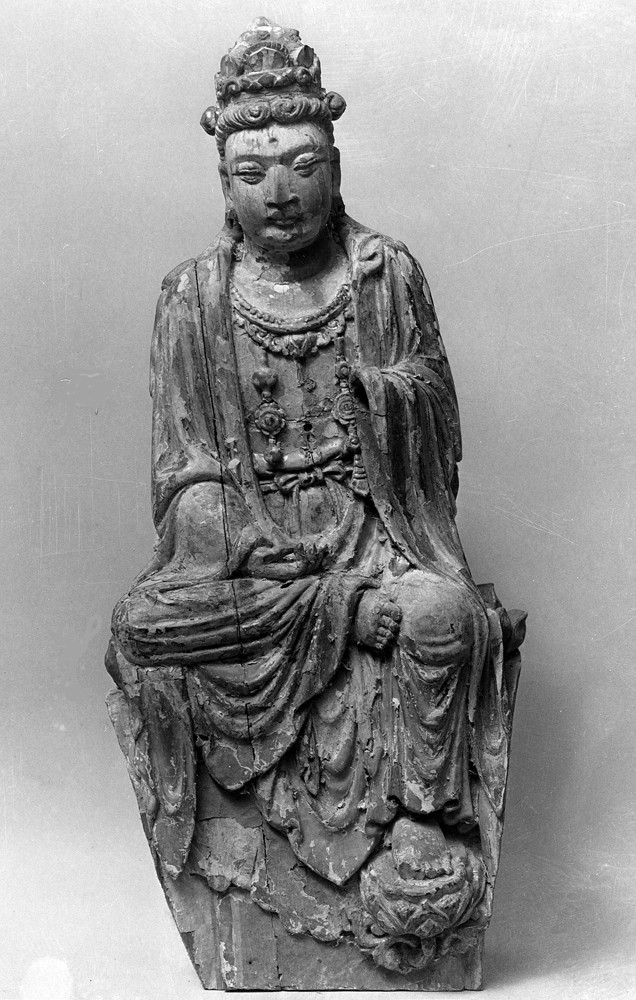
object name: statuette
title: Statuette of Bodhisattva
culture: chinese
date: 1368-1644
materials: wood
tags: bodhisattvas